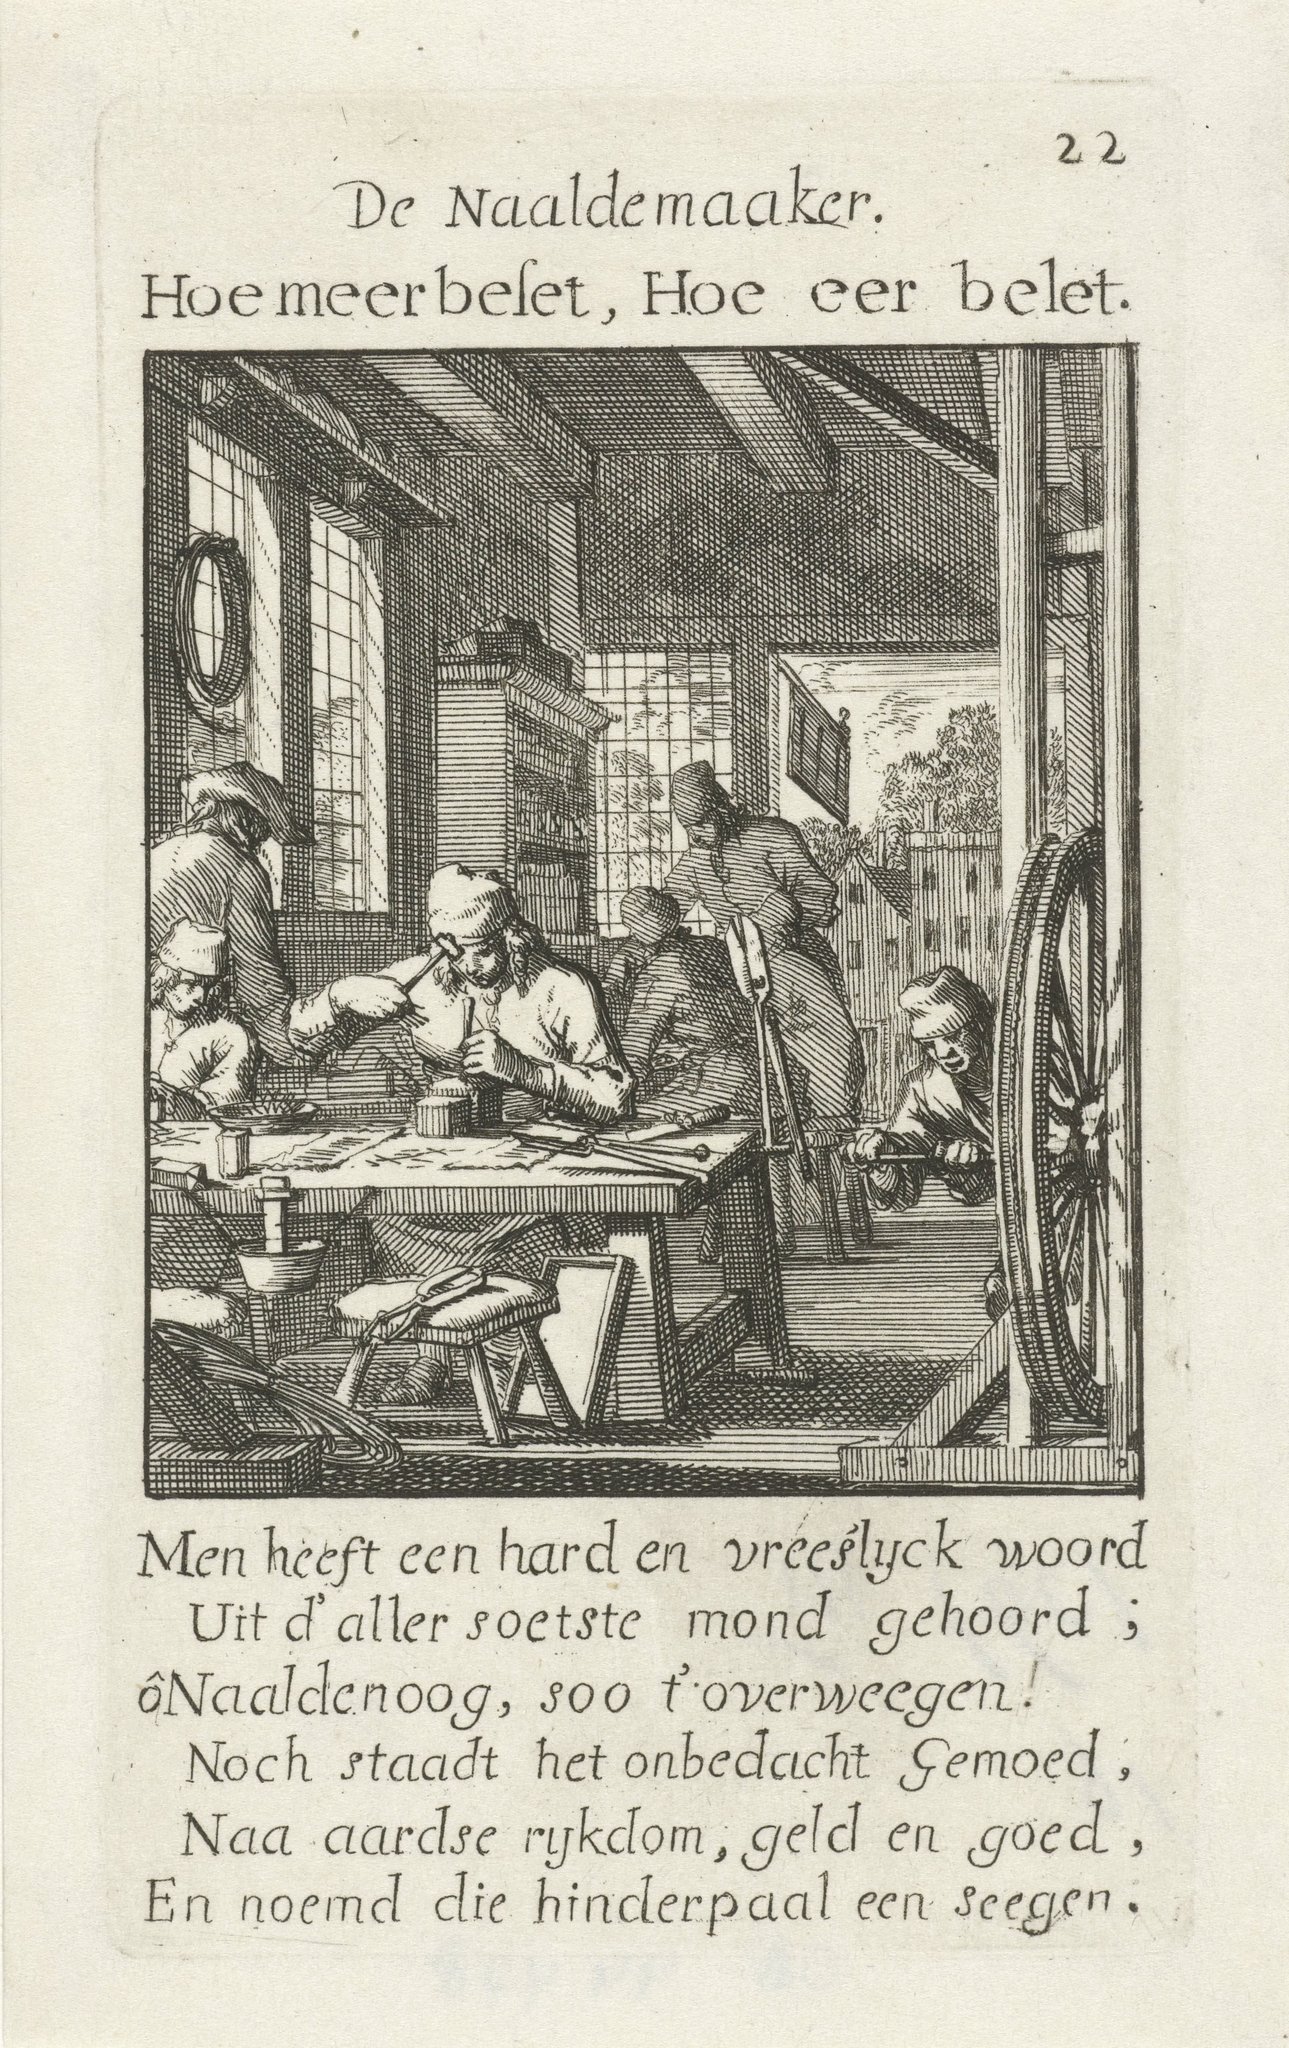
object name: print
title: De Naaldemaaker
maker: jan luyken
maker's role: draughtsman, print maker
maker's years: 1649-1712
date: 1694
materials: paper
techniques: etching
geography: amsterdam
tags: handicrafts, craftsman at work, needle ~ sewing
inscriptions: collector's mark: Lugt 2228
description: Maakt deel uit van de 100-delige serie beroepsprenten van Jan en Caspar Luyken, getiteld: Het menselyk bedryf. S.l.s.n., 1694 (eerste druk).